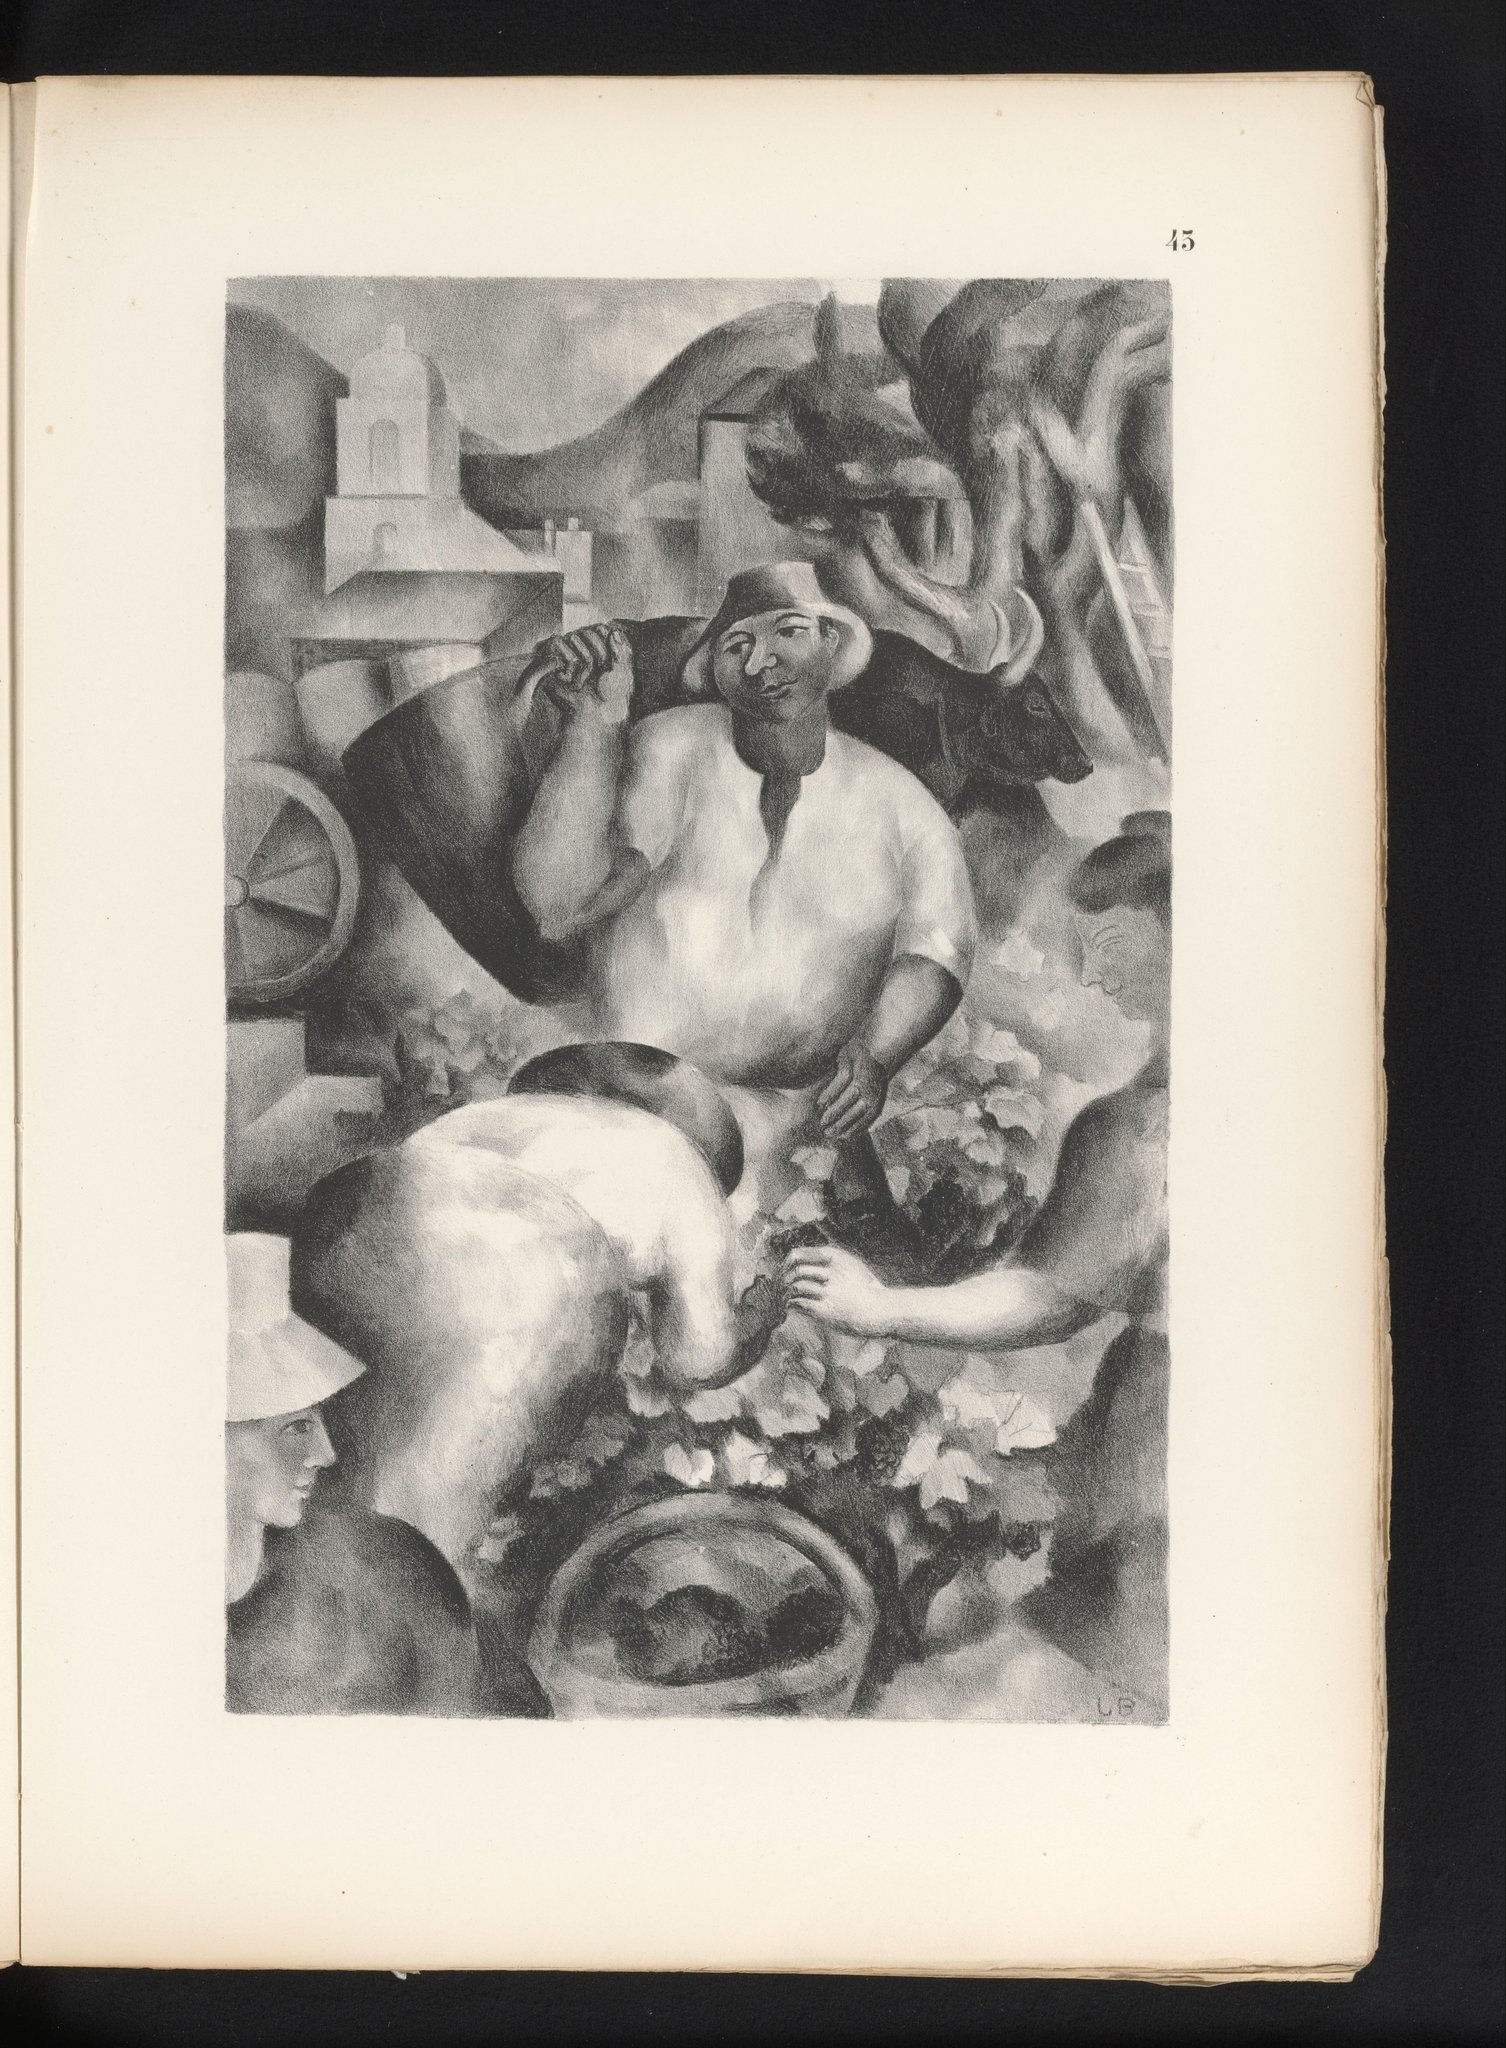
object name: page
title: Vier figuren tijdens druivenoogst met een buffel op de achtergrond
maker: jean-louis boussingault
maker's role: painter, print maker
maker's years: 1883-1943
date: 1921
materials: paper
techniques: lithograph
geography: paris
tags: bull, vintage, grape harvest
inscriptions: collector's mark: Lugt 2228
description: Prent uit: Valéry, Paul et al. Architectures. Recueil publié sous le direction de Louis Suë & André Mare comprenant un dialogue de Paul Valéry et la présentation d'ouvrages d'architecture, décoration intérieure, peinture, sculpture et gravure contribuant depuis mil neuf cent quatorze a former le style français. Parijs: Éditions de la nouvelle revue française, 1921, p. 43.